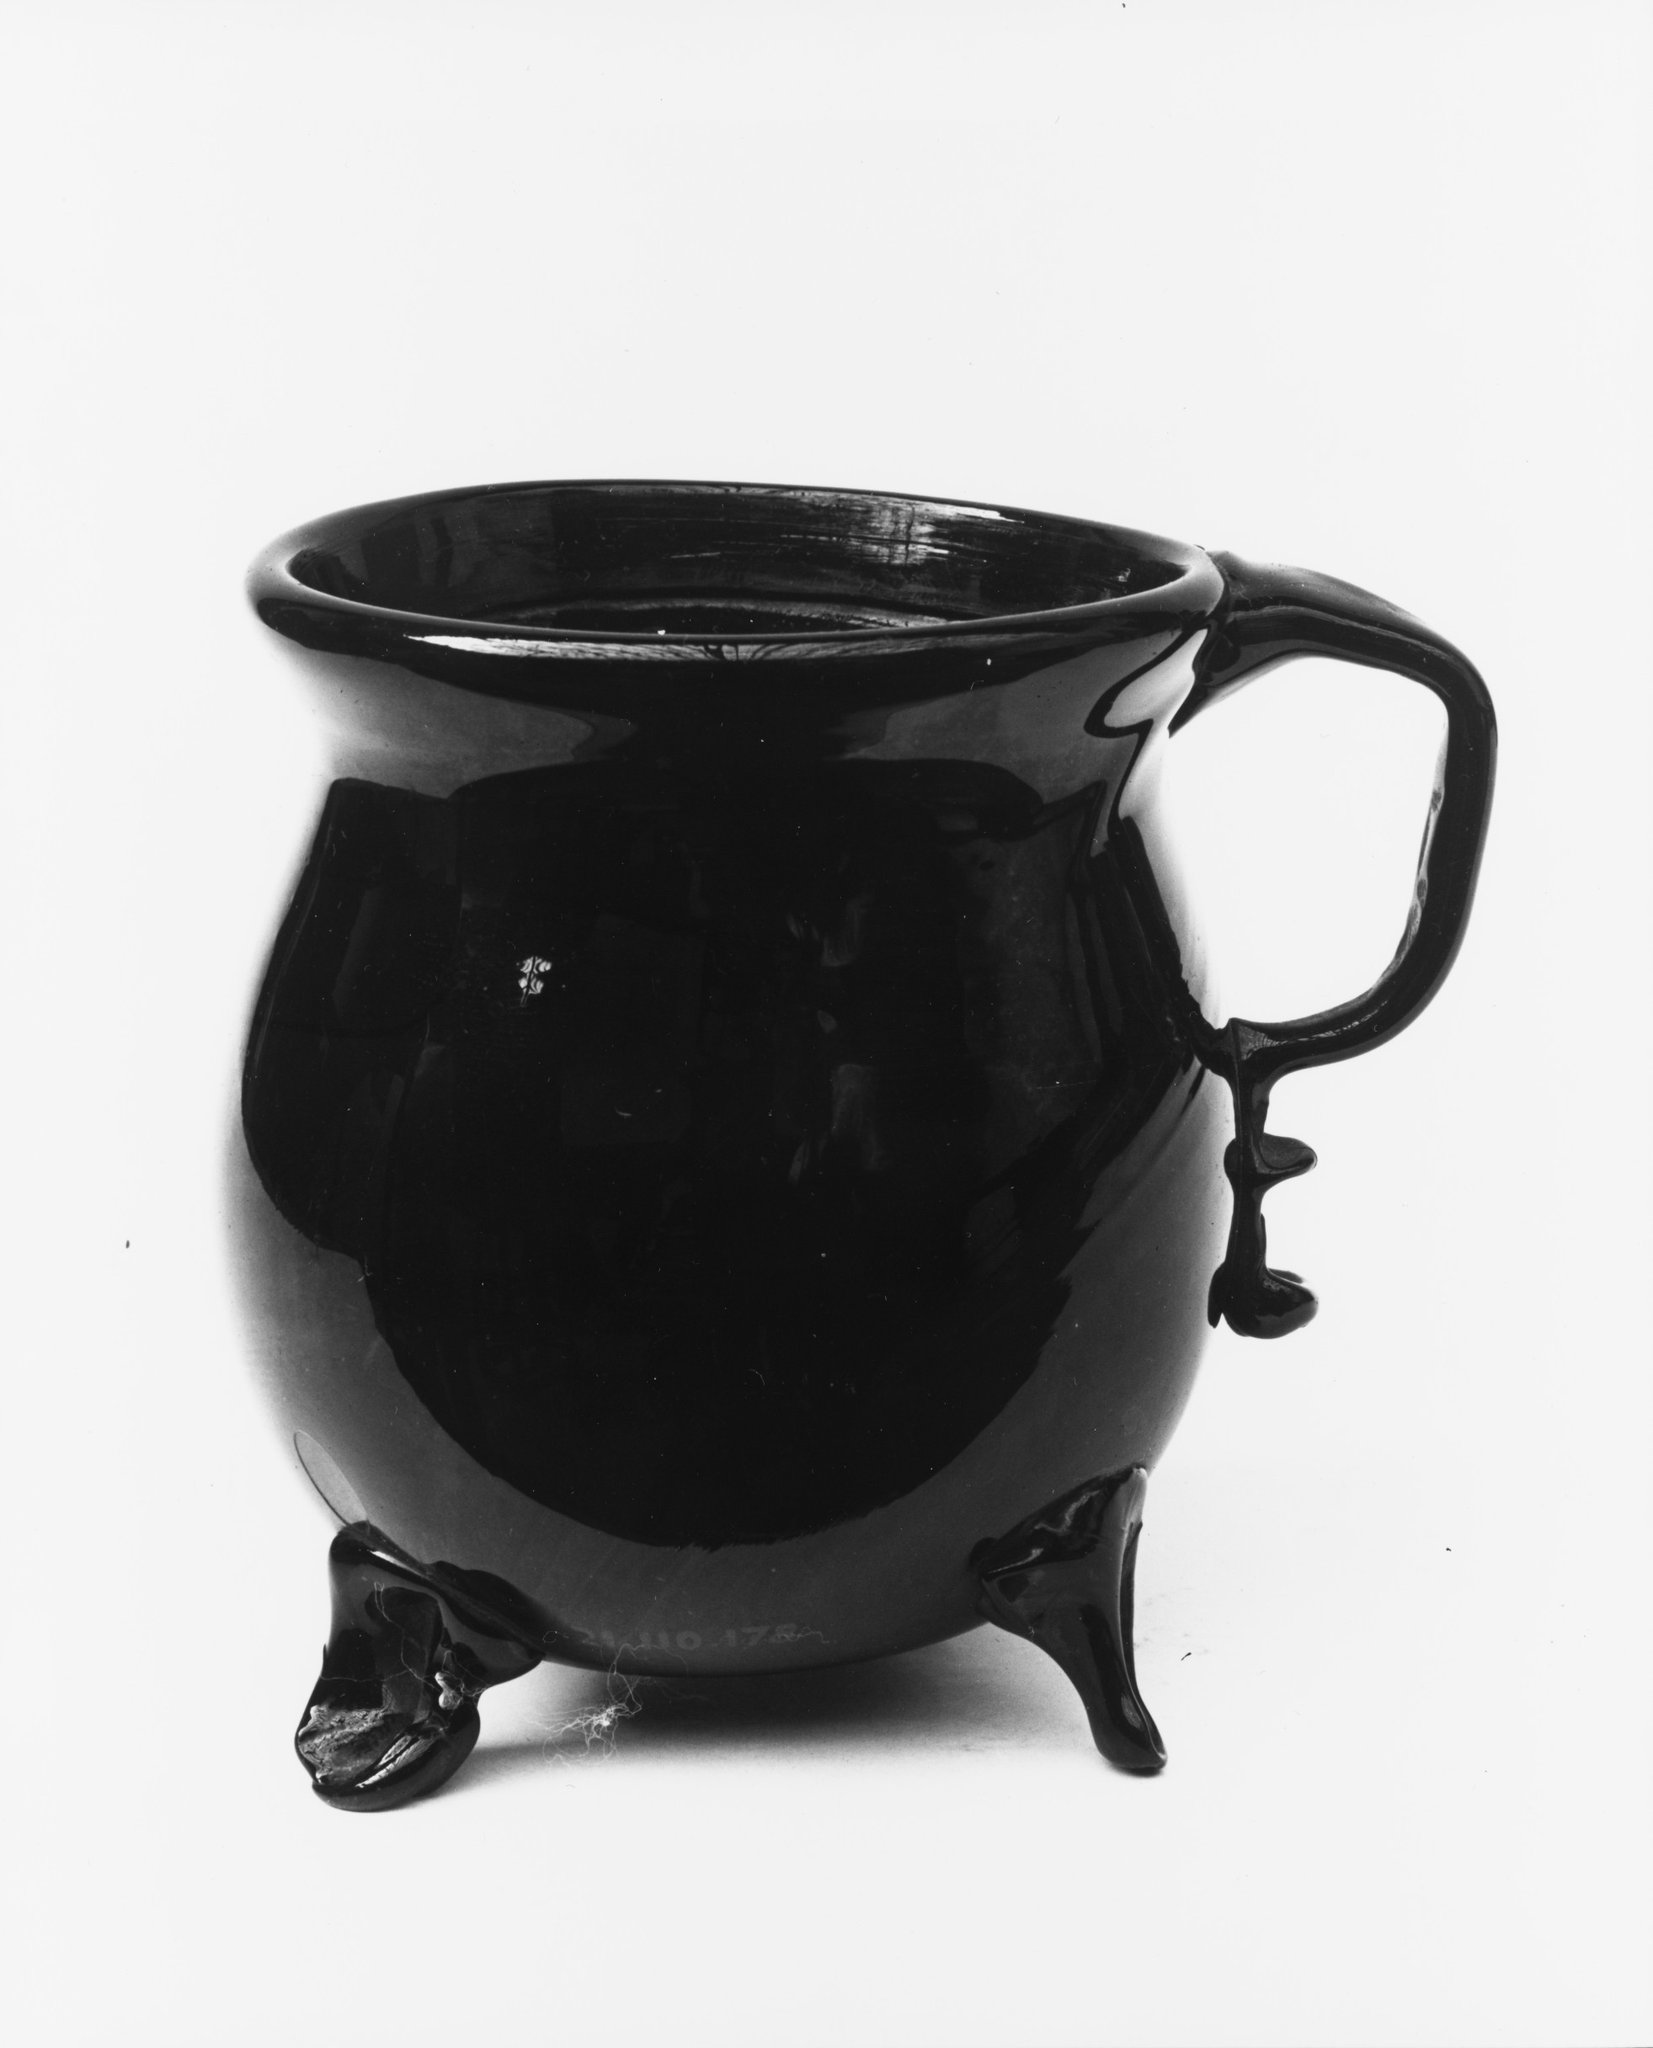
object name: mug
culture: american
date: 1700-1800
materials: amber, glass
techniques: glassblowing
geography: united states